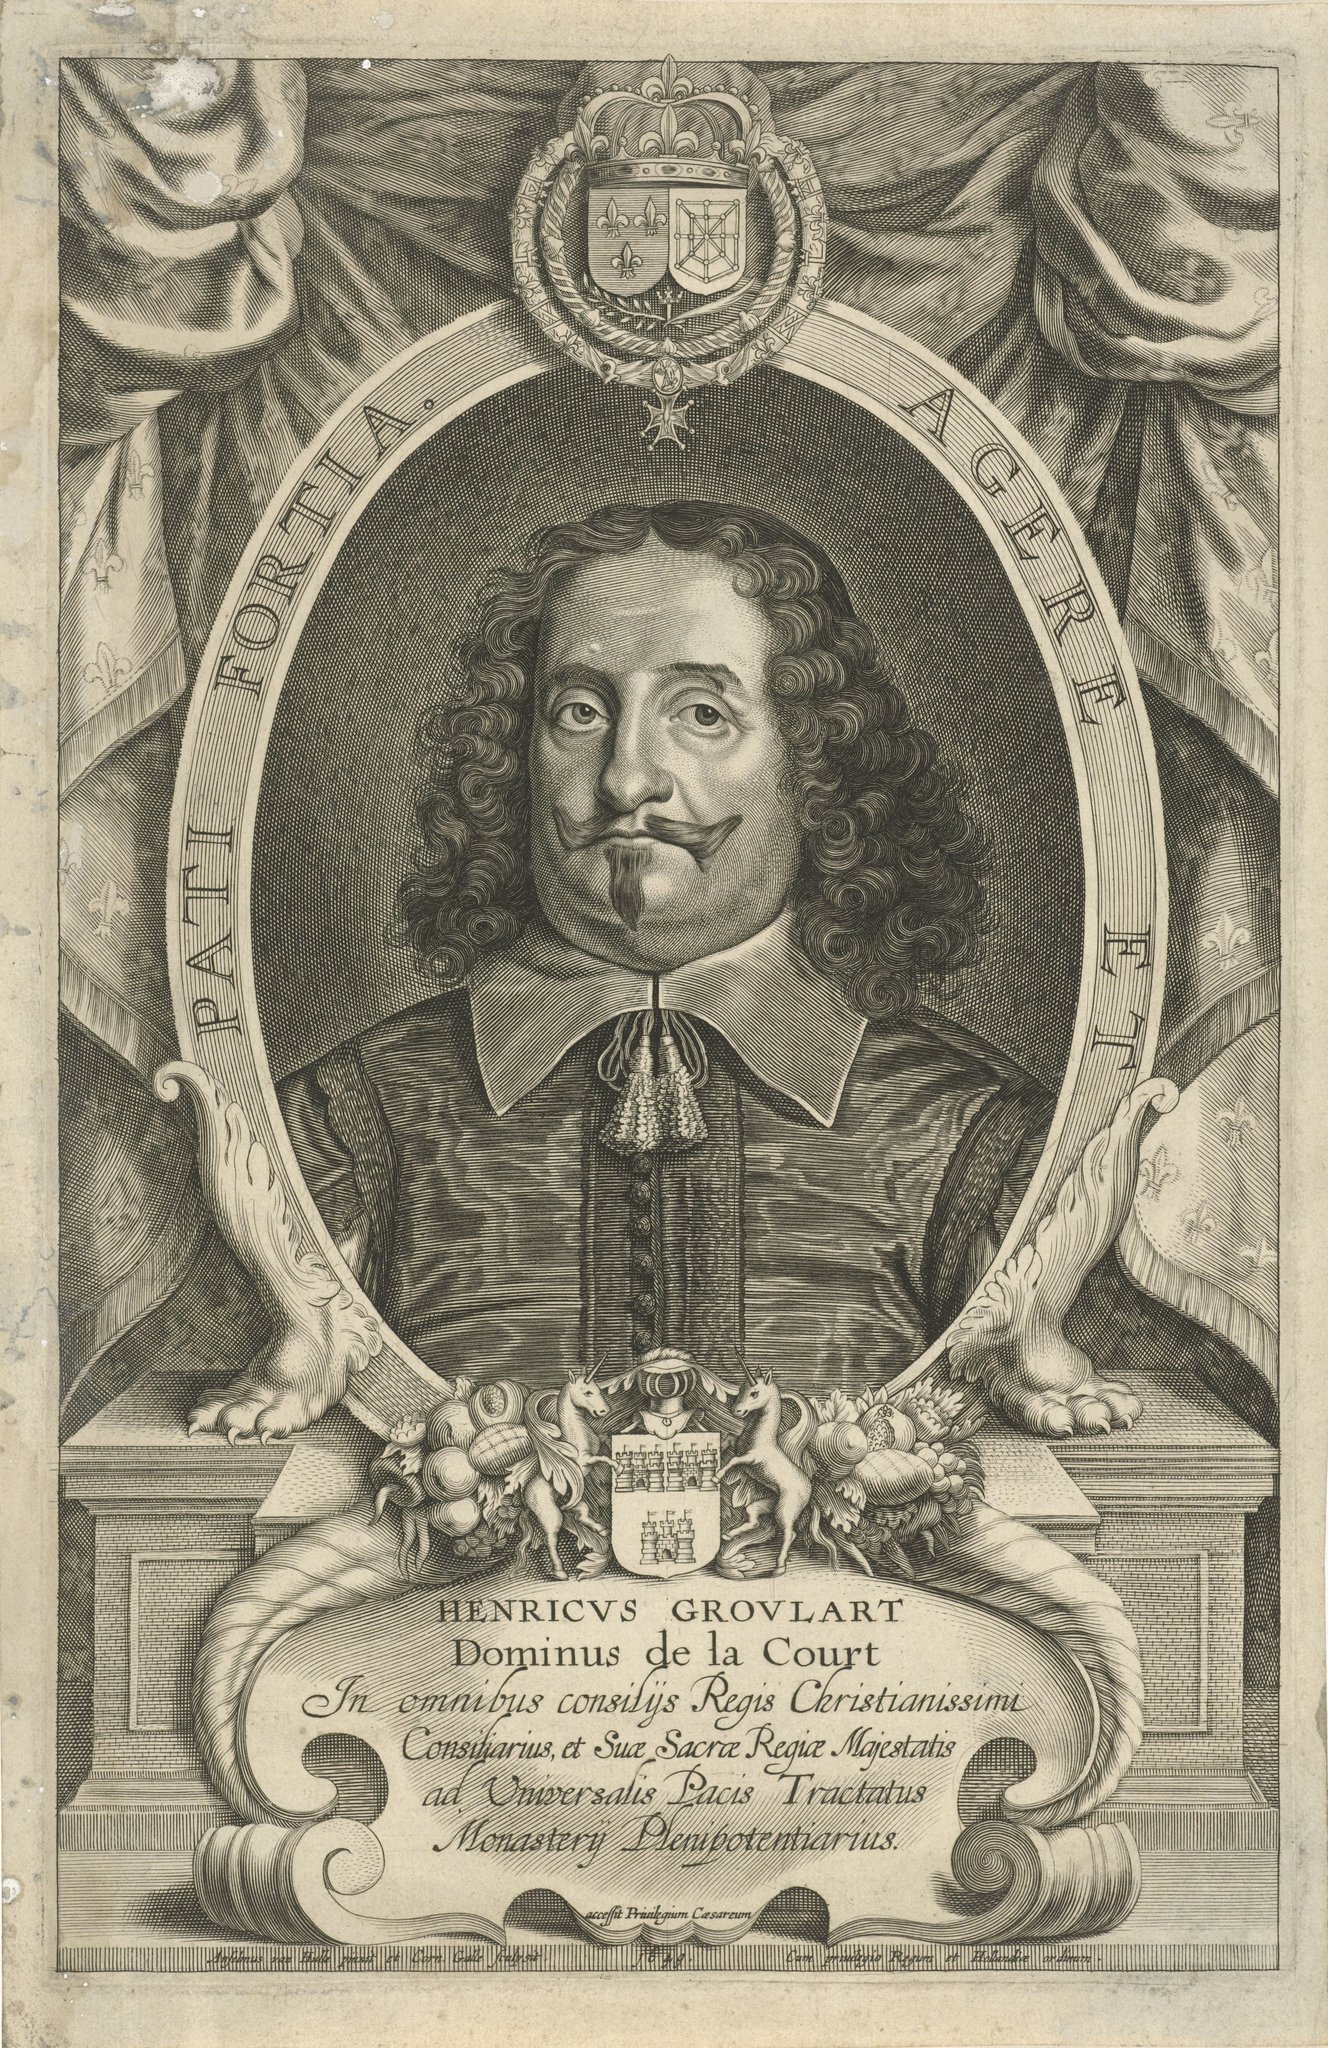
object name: print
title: Portret van Henri Groulart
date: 1649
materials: paper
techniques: engraving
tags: henri groulart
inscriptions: collector's mark: Lugt 2228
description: Portret van Henri Groulart, in een ovale sierlijst met familiewapens. Met motto: Agere et pati fortia. Achter de lijst een draperie met Franse lelies.